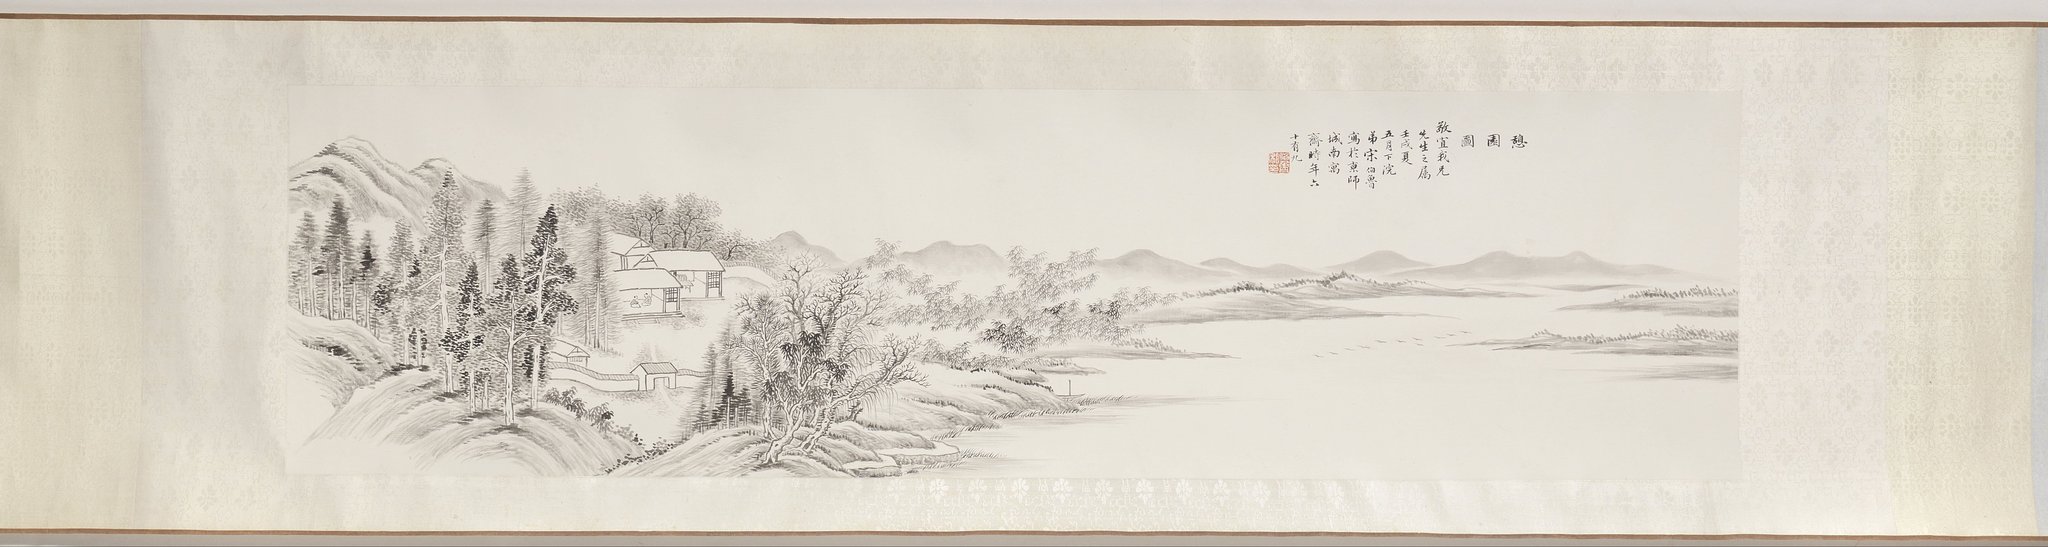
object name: hanging scroll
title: The Garden of Serenity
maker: song bolu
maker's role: painter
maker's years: 1854-1932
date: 1922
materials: ink, paper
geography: liquan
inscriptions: date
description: This painting depicts the visit of a friend to a scholar in the garden of his home, where he escapes from society to live as a reclusive hermit. The artist did not aim to render a realistic landscape, but rather make an idealized portrait of the life of a hermit.